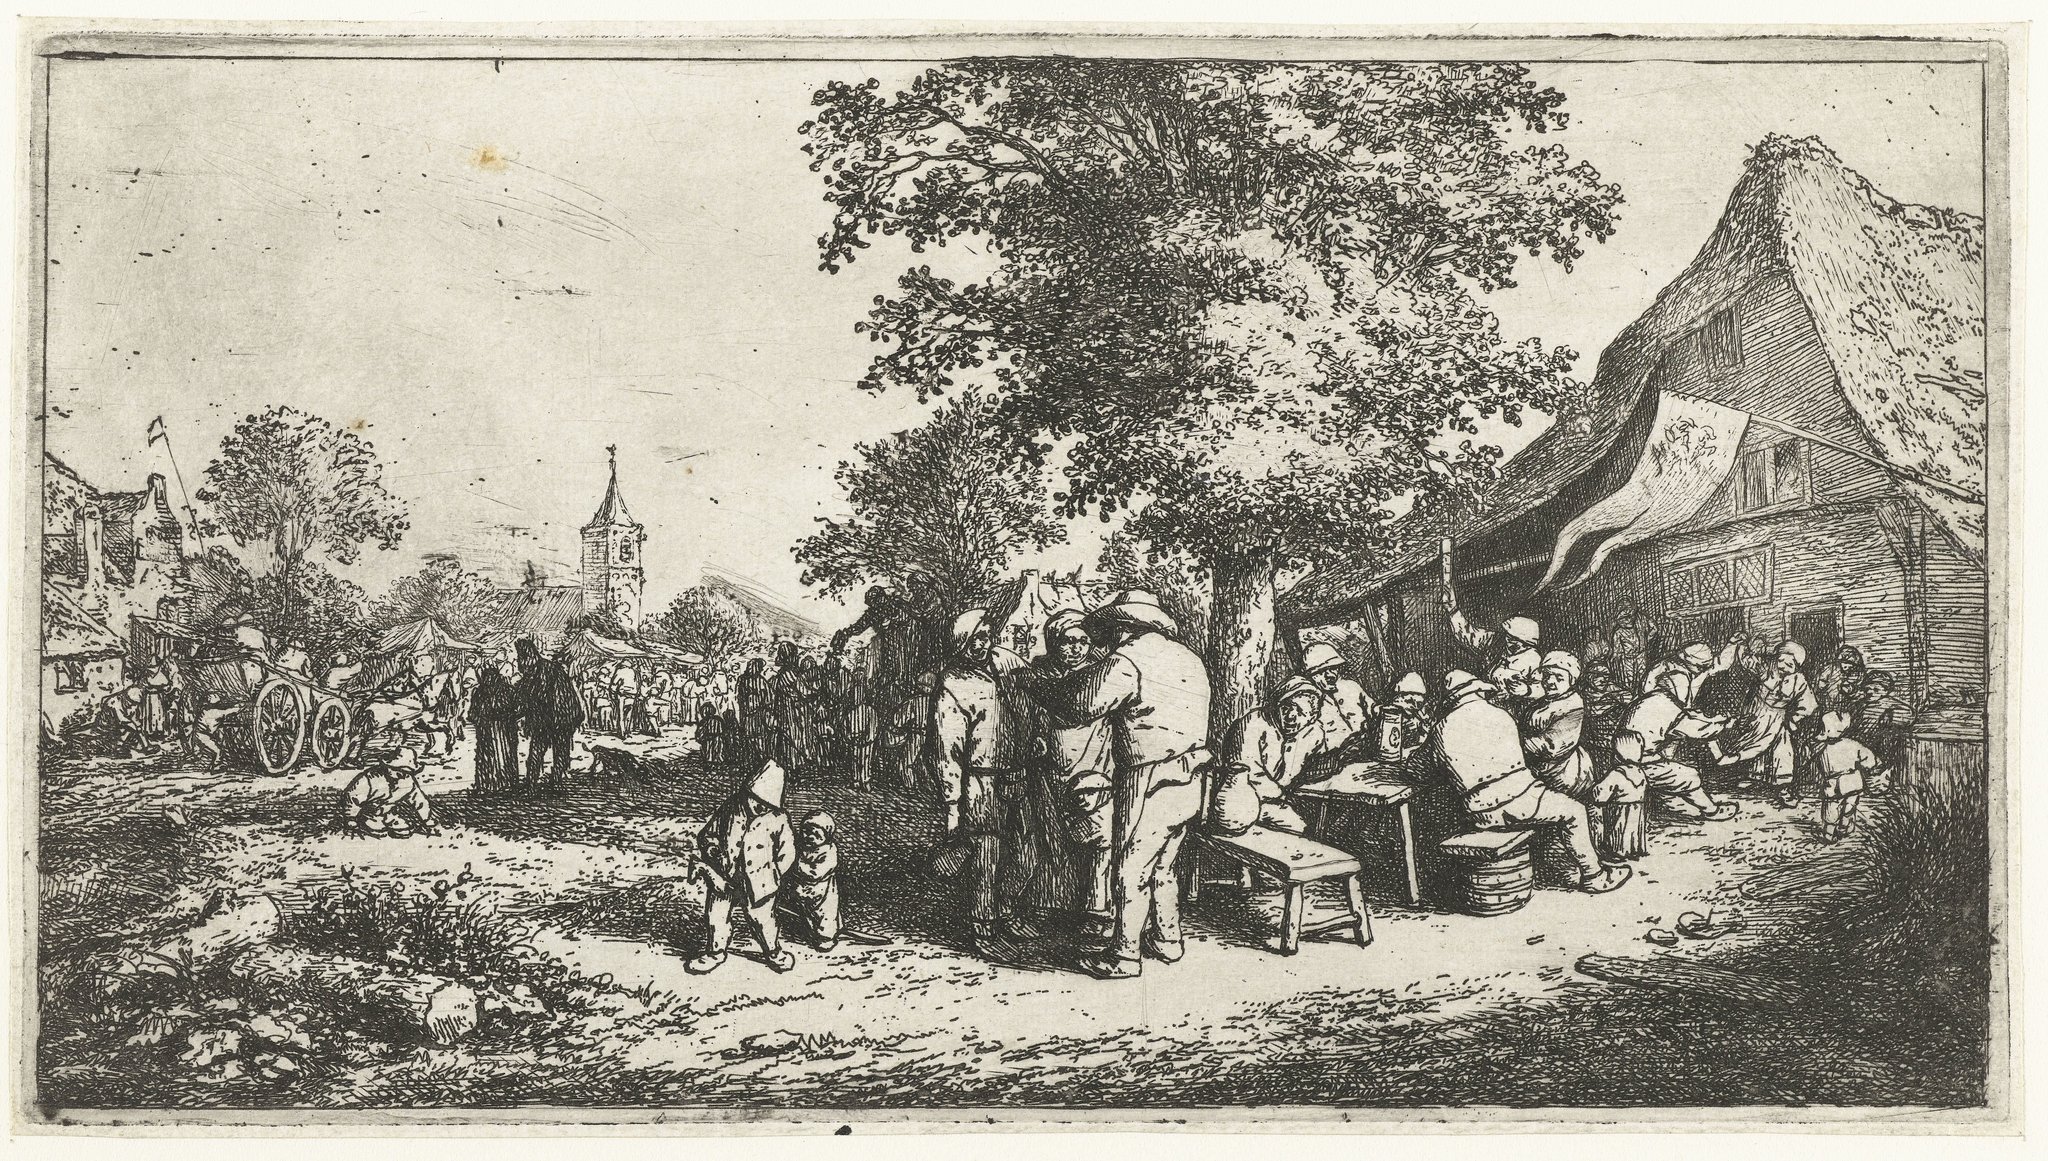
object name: print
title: Boerenkermis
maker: adriaen van ostade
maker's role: draughtsman, painter, print maker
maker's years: 1610-1685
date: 1652-1656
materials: paper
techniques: etching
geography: haarlem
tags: pleasure fair and circus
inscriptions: collector's mark: Lugt 567, collector's mark: Lugt 2760, collector's mark: Lugt 2228a, collector's mark: Lugt 2794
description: In een dorpsstraat vindt een boerenkermis plaats met veel vermaak. Boeren dansen en drinken bij een herberg en in de straat staan marktkramen. Twee kinderen spelen met een stokpaard en een bedelaar zoekt zijn weg.